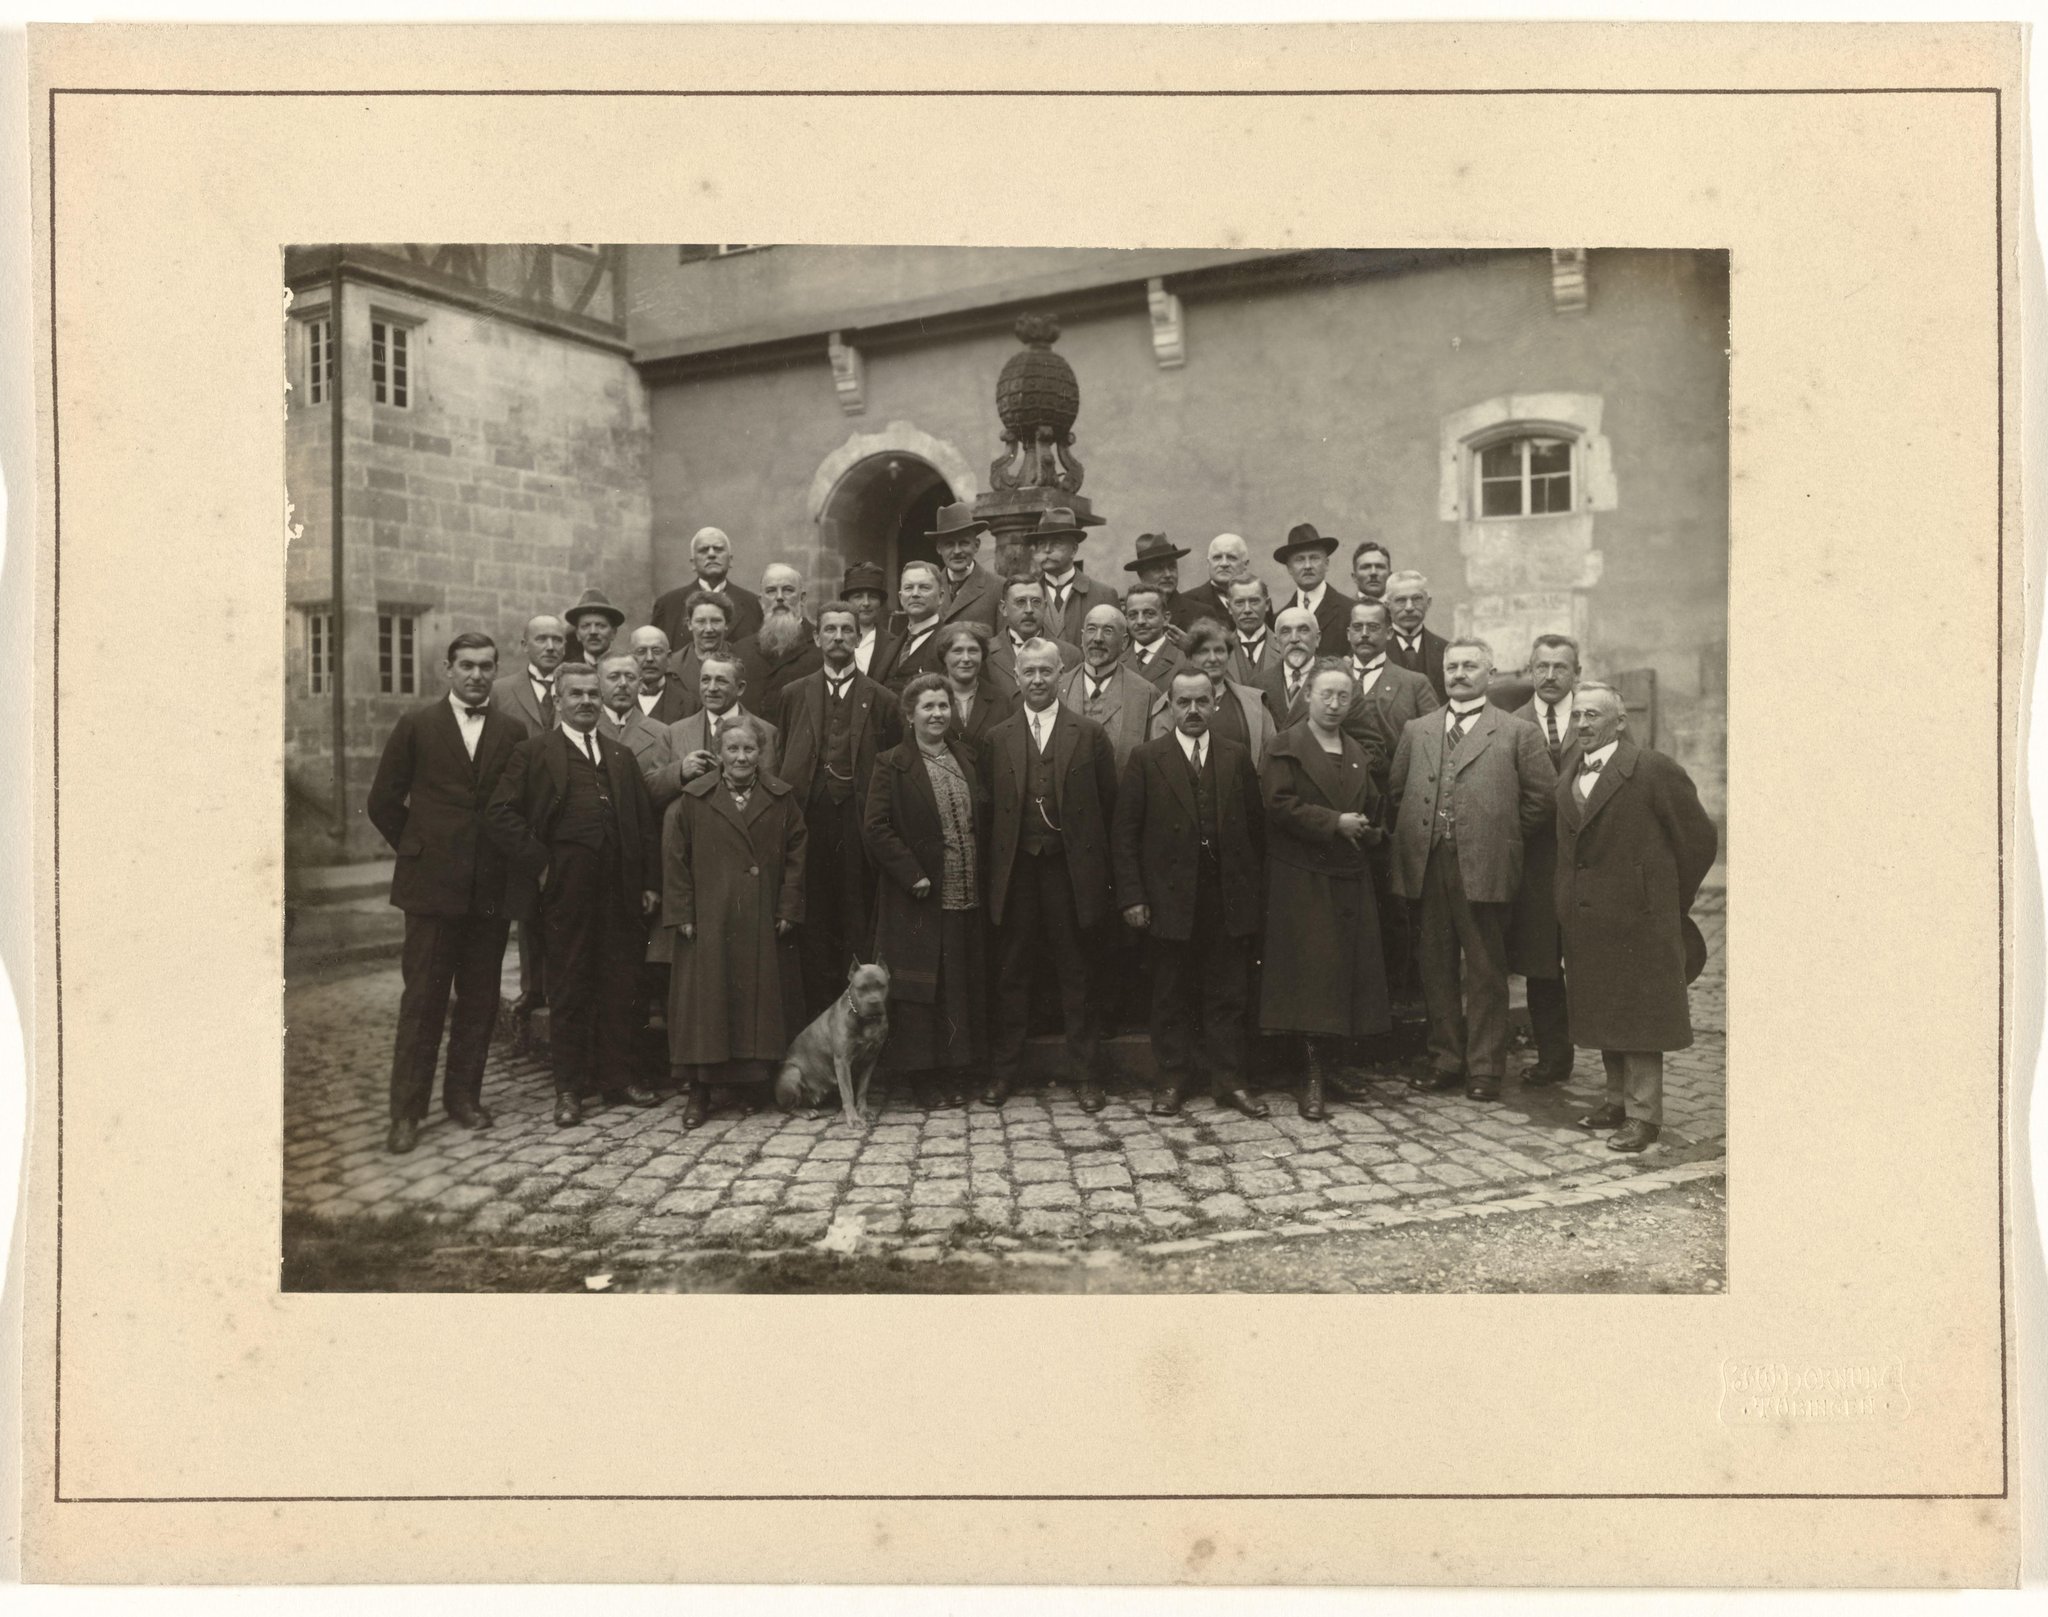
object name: photograph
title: Meir Wachenheimer op een plein met onbekende mannen en vrouwen, 1896-1935, Tübingen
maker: Anonymous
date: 1896-1935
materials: photographic support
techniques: gelatin silver print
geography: tübingen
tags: meir wachenheimer, tübingen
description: Meir Wachenheimer (links van de fontein, staand, helemaal achterin de rij, naast man met grote baard) en onbekende mannen en vrouwen